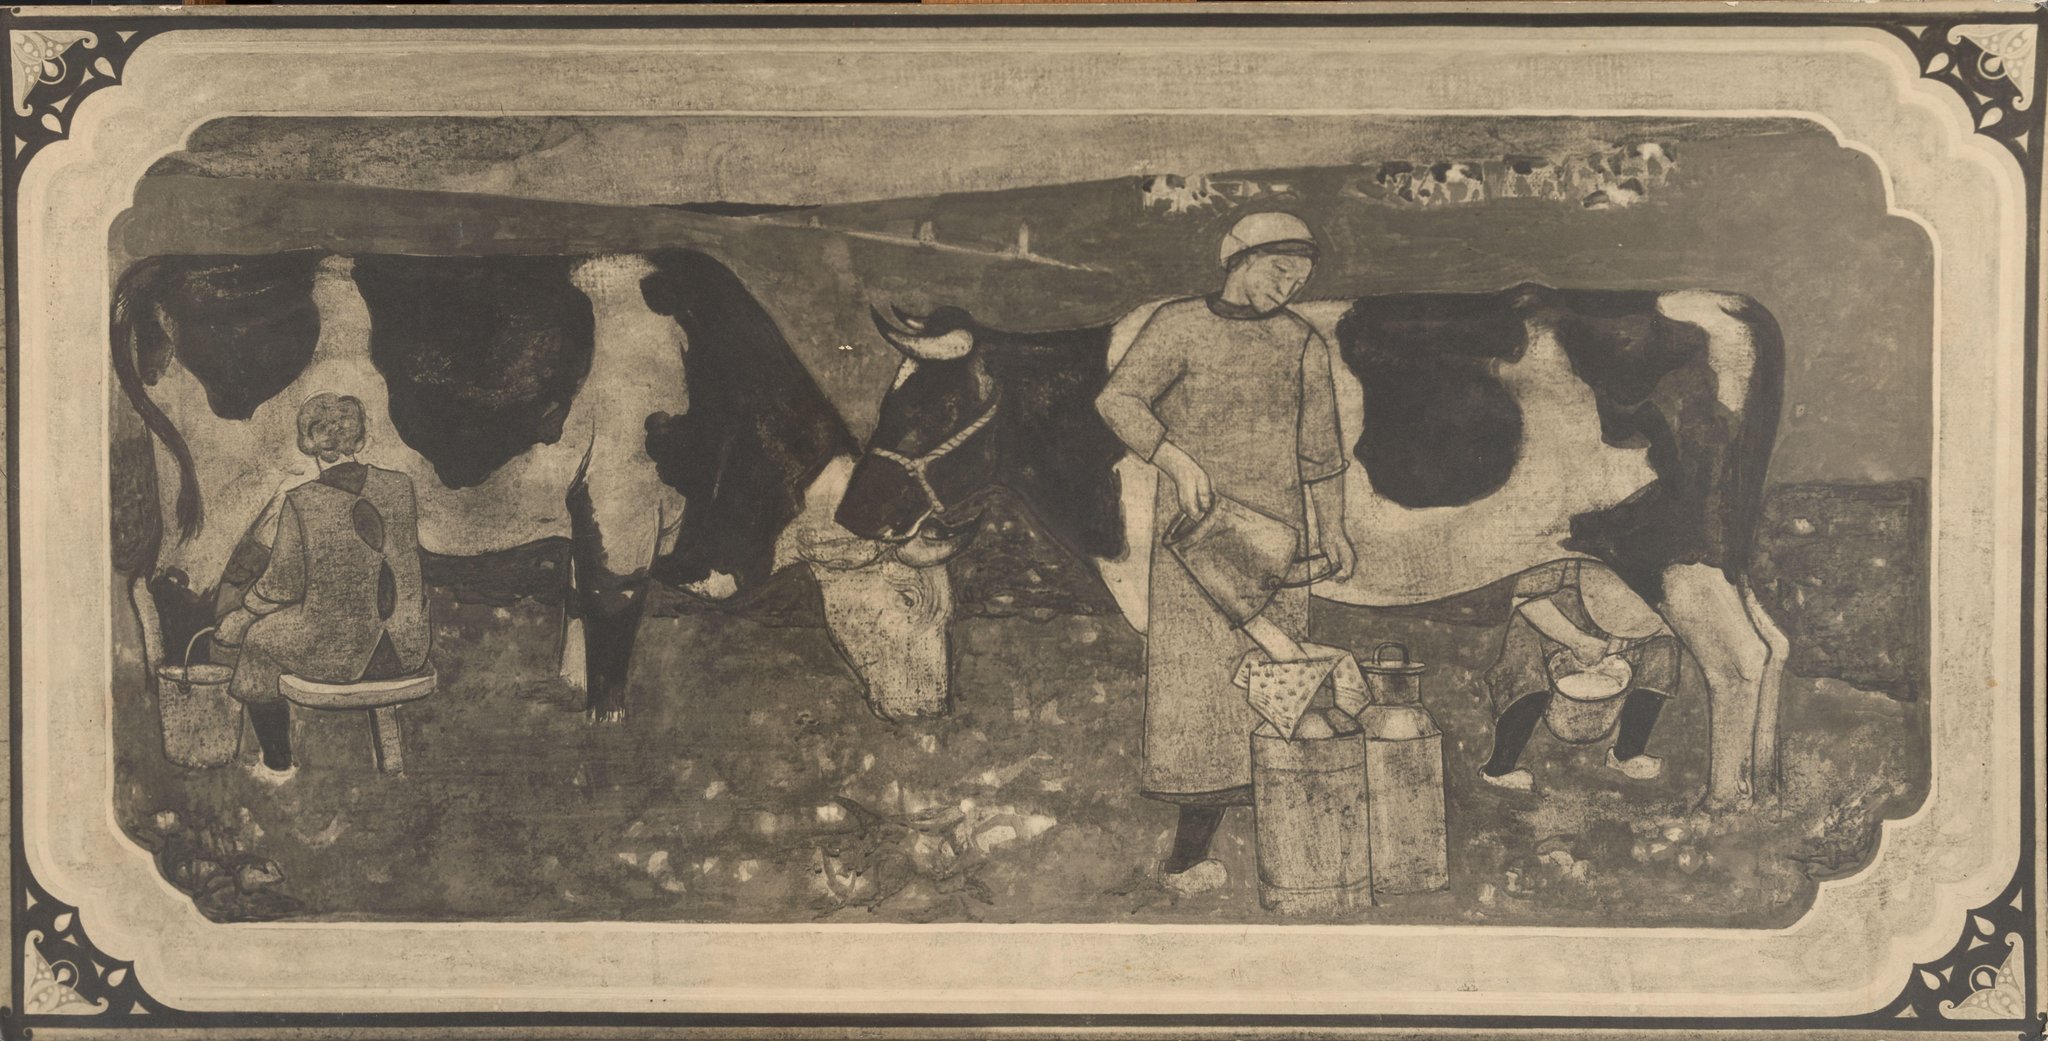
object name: photograph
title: Fotoreproductie van ontwerptekening met boerinnen en koeien voor glas-in-loodraam door Richard Roland Holst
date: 1909-1914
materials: cardboard, photographic support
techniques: gelatin silver print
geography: hilversum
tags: cow, farmers - aa - female farmer, farmer's wife, milkmaid, milking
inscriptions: inscription: ‘R.N. Roland Holst/ Heidemaarschappij, Arnhem/ (Geschenk L. Boermeester)’, label: ‘Opname/ C.A. Deul./ Emmastr. 4, Hilversum’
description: Ontwerptekening voor glas-in-loodraam voor het gebouw van de Nederlandsche Heidemaatschappij te Arnhem, ook wel bekend als De Bazel.